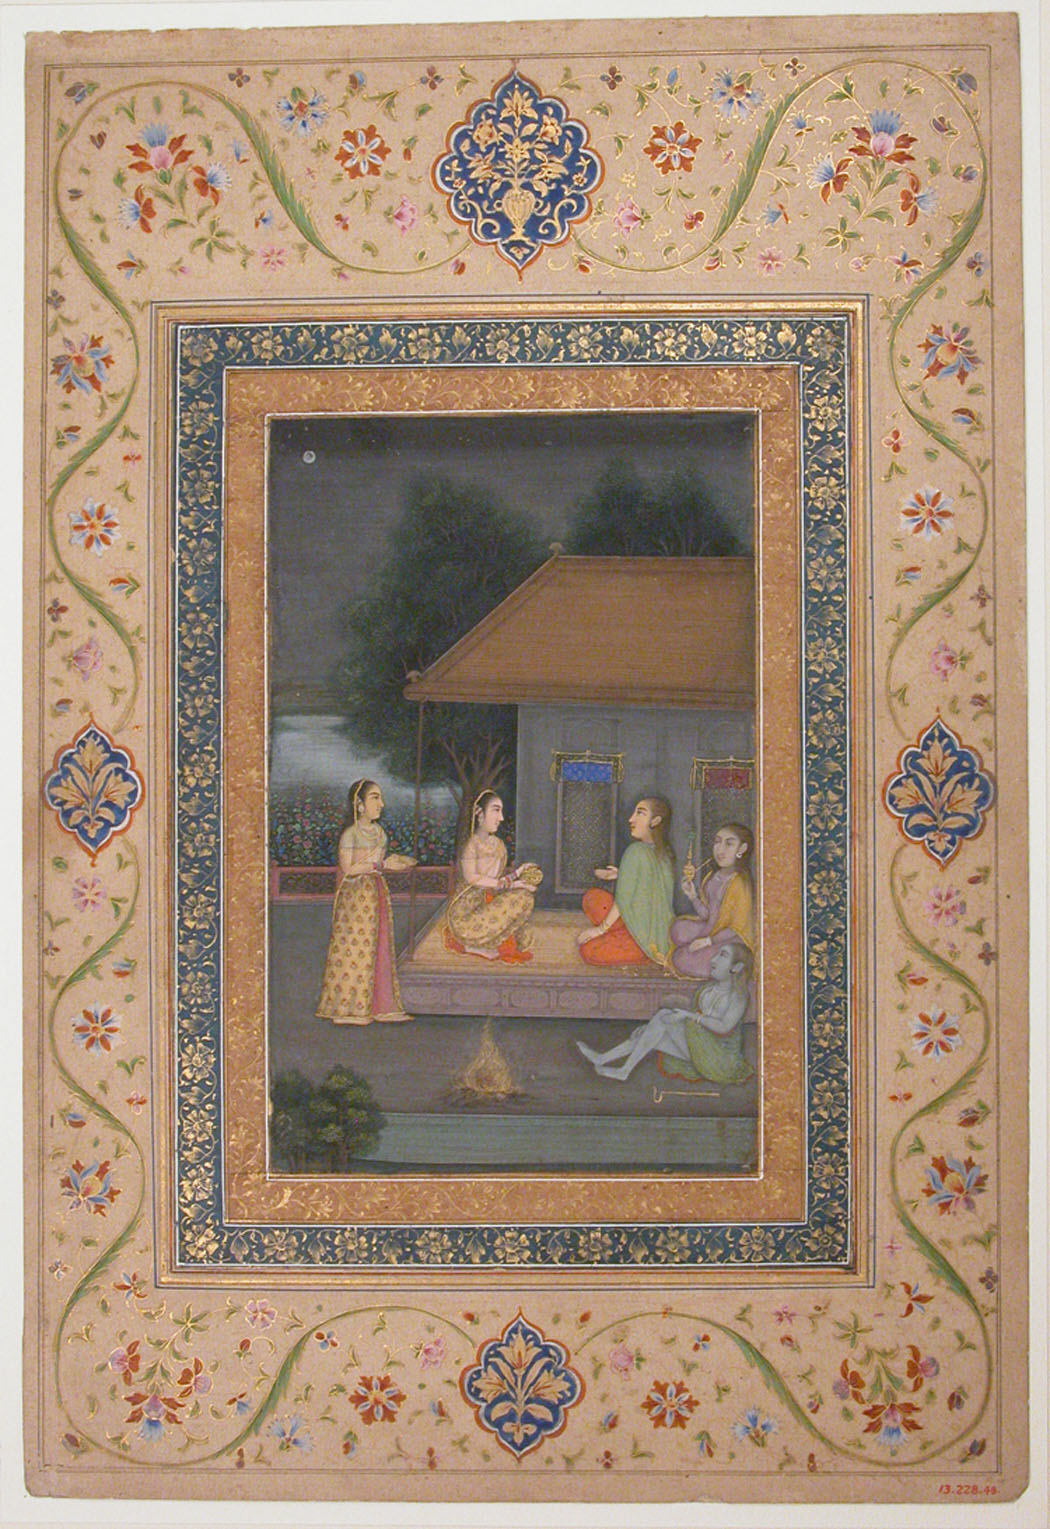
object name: illustrated album leaf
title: Women Conversing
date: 1601-1700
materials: gold, ink, paper, watercolor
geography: india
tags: houses,women,fire